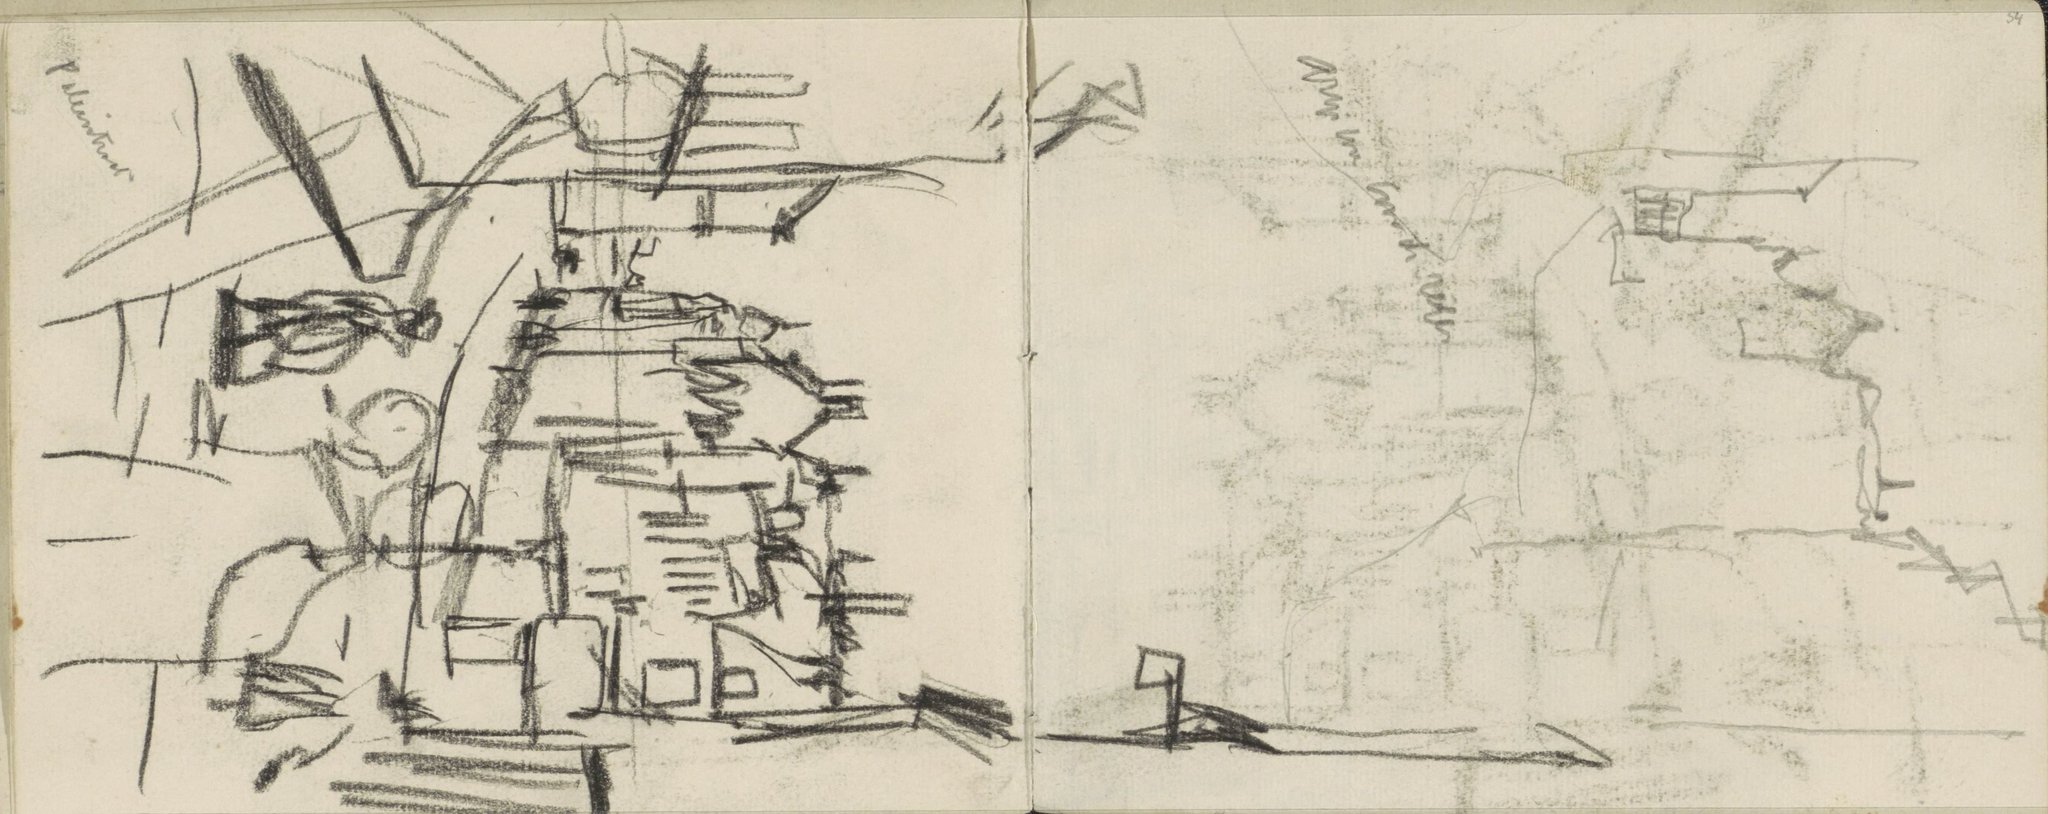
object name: sketchbook leaf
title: Twee gezichten op de Paleisstraat te Amsterdam, gezien vanaf de brug over het Singel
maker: george hendrik breitner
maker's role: draughtsman, painter, print maker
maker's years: 1857-1923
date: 1886-1903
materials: chalk, paper, pencil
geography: amsterdam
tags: civic architecture; edifices; dwellings, street (+ city(-scape) with figures, staffage), royal palace of amsterdam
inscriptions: annotation: ‘Paleisstraat’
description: Links het Koninklijk Paleis. Pagina 53 en pagina 54 uit een schetsboek met 32 bladen.